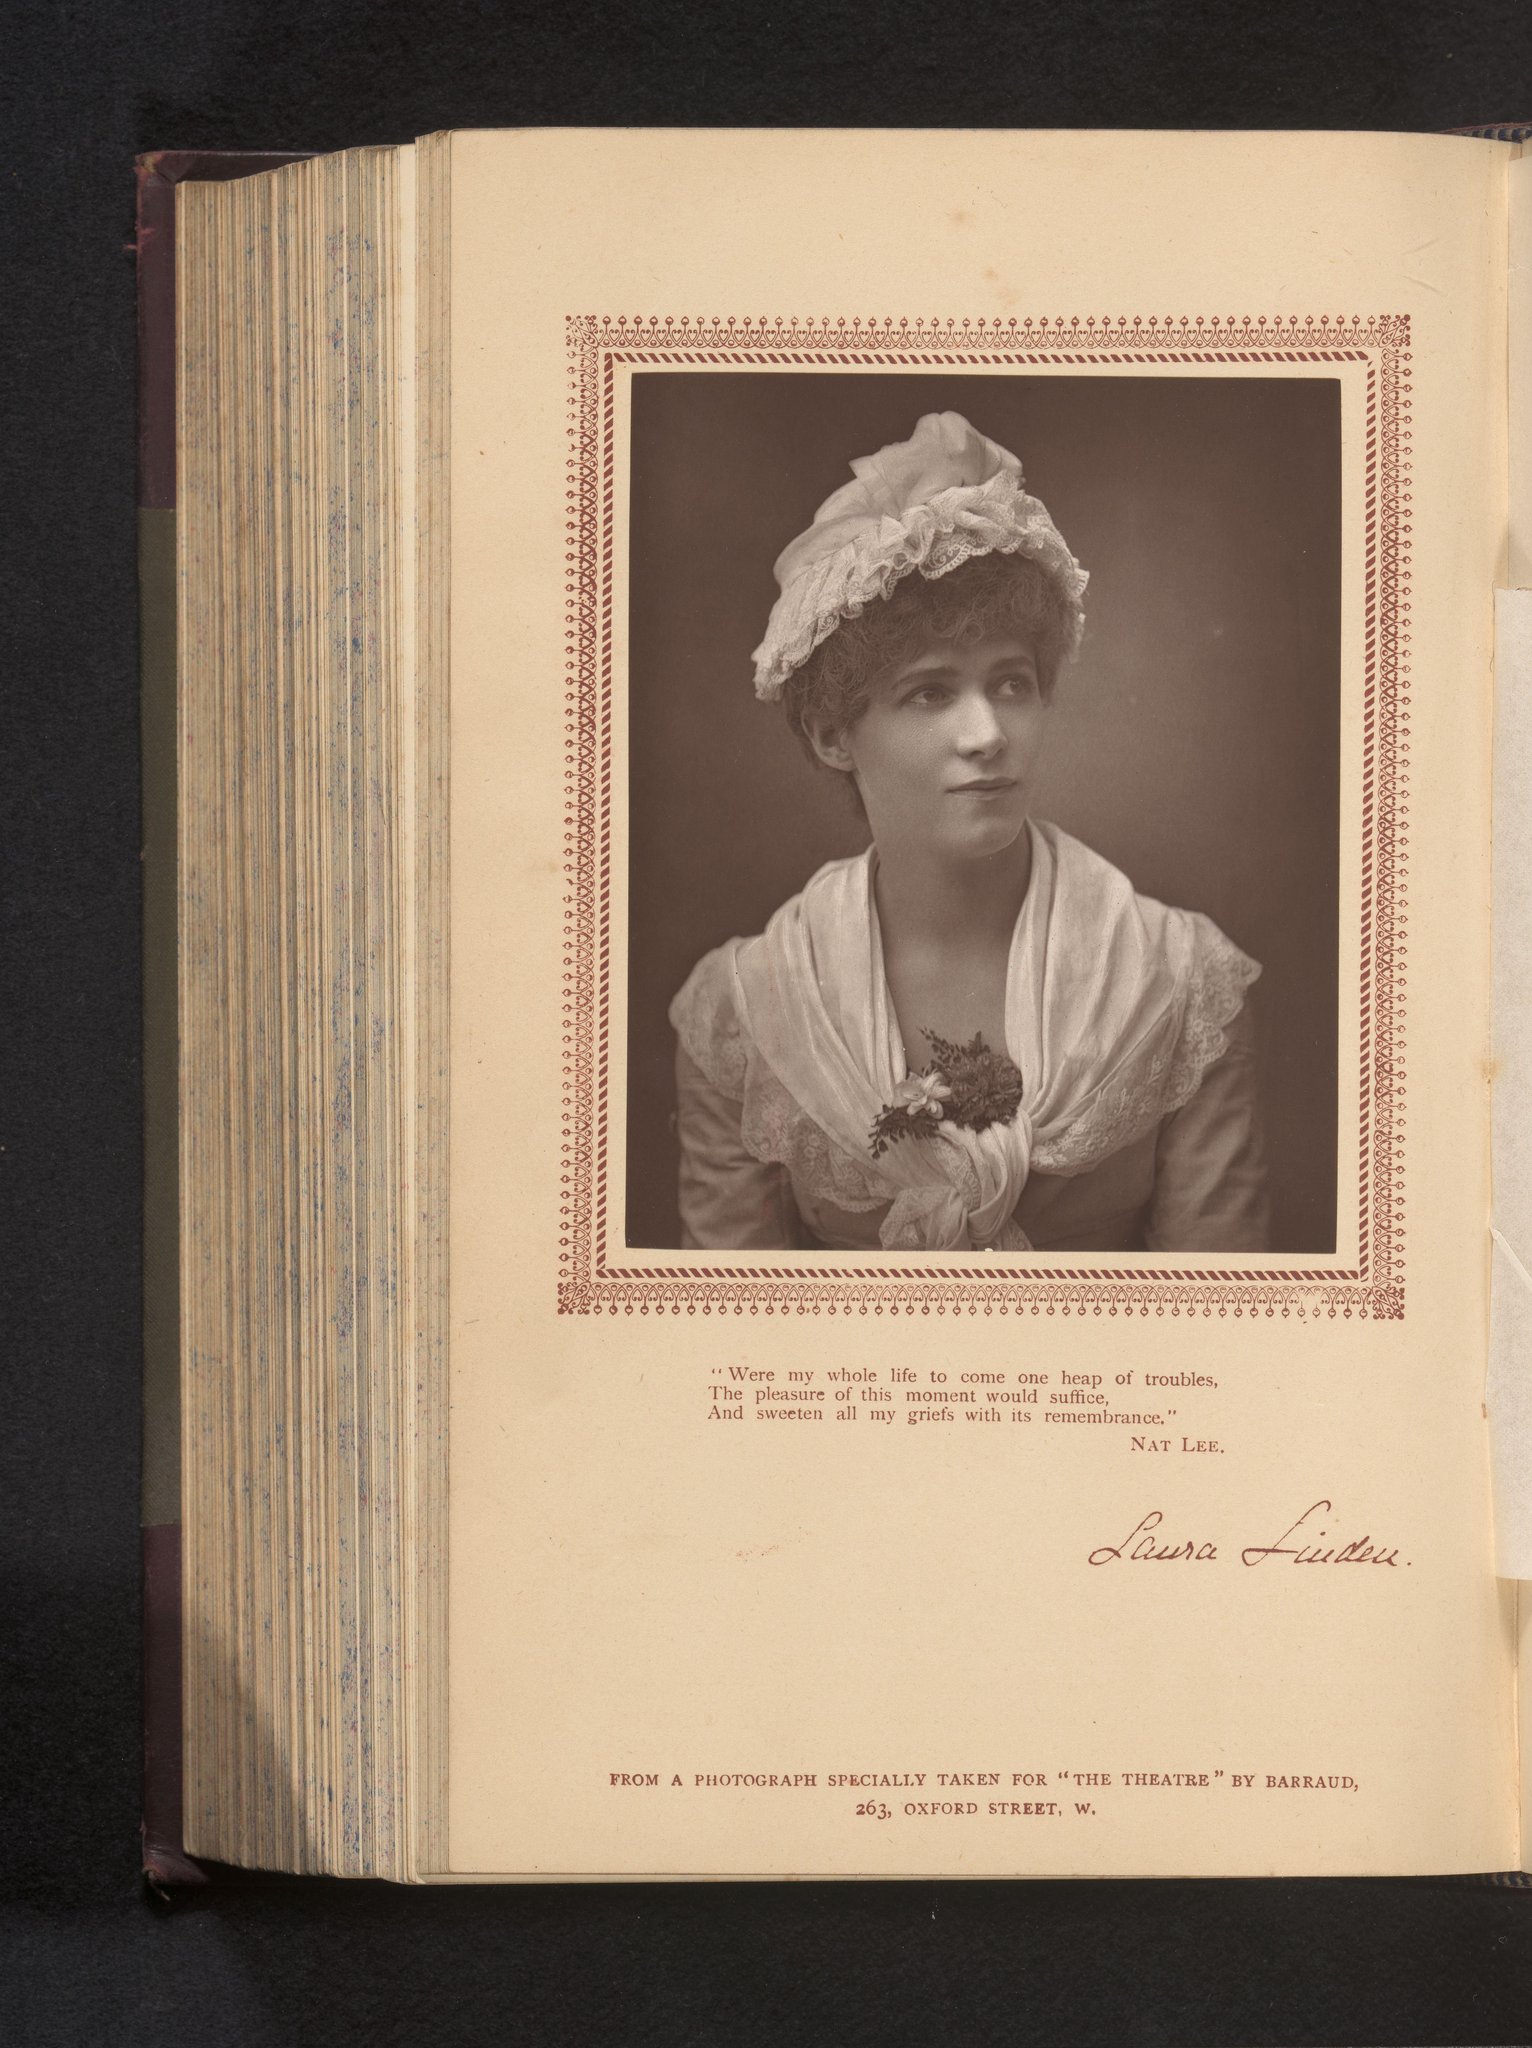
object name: photomechanical print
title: Portret van Laura Linden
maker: herbert rose barraud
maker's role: fotograaf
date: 1880-1885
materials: paper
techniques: woodburytype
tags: adult woman, historical persons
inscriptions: inscription: ‘'Were my whole life to come one heap of troubles,/ (...)’, signature: ‘Laura Linden’